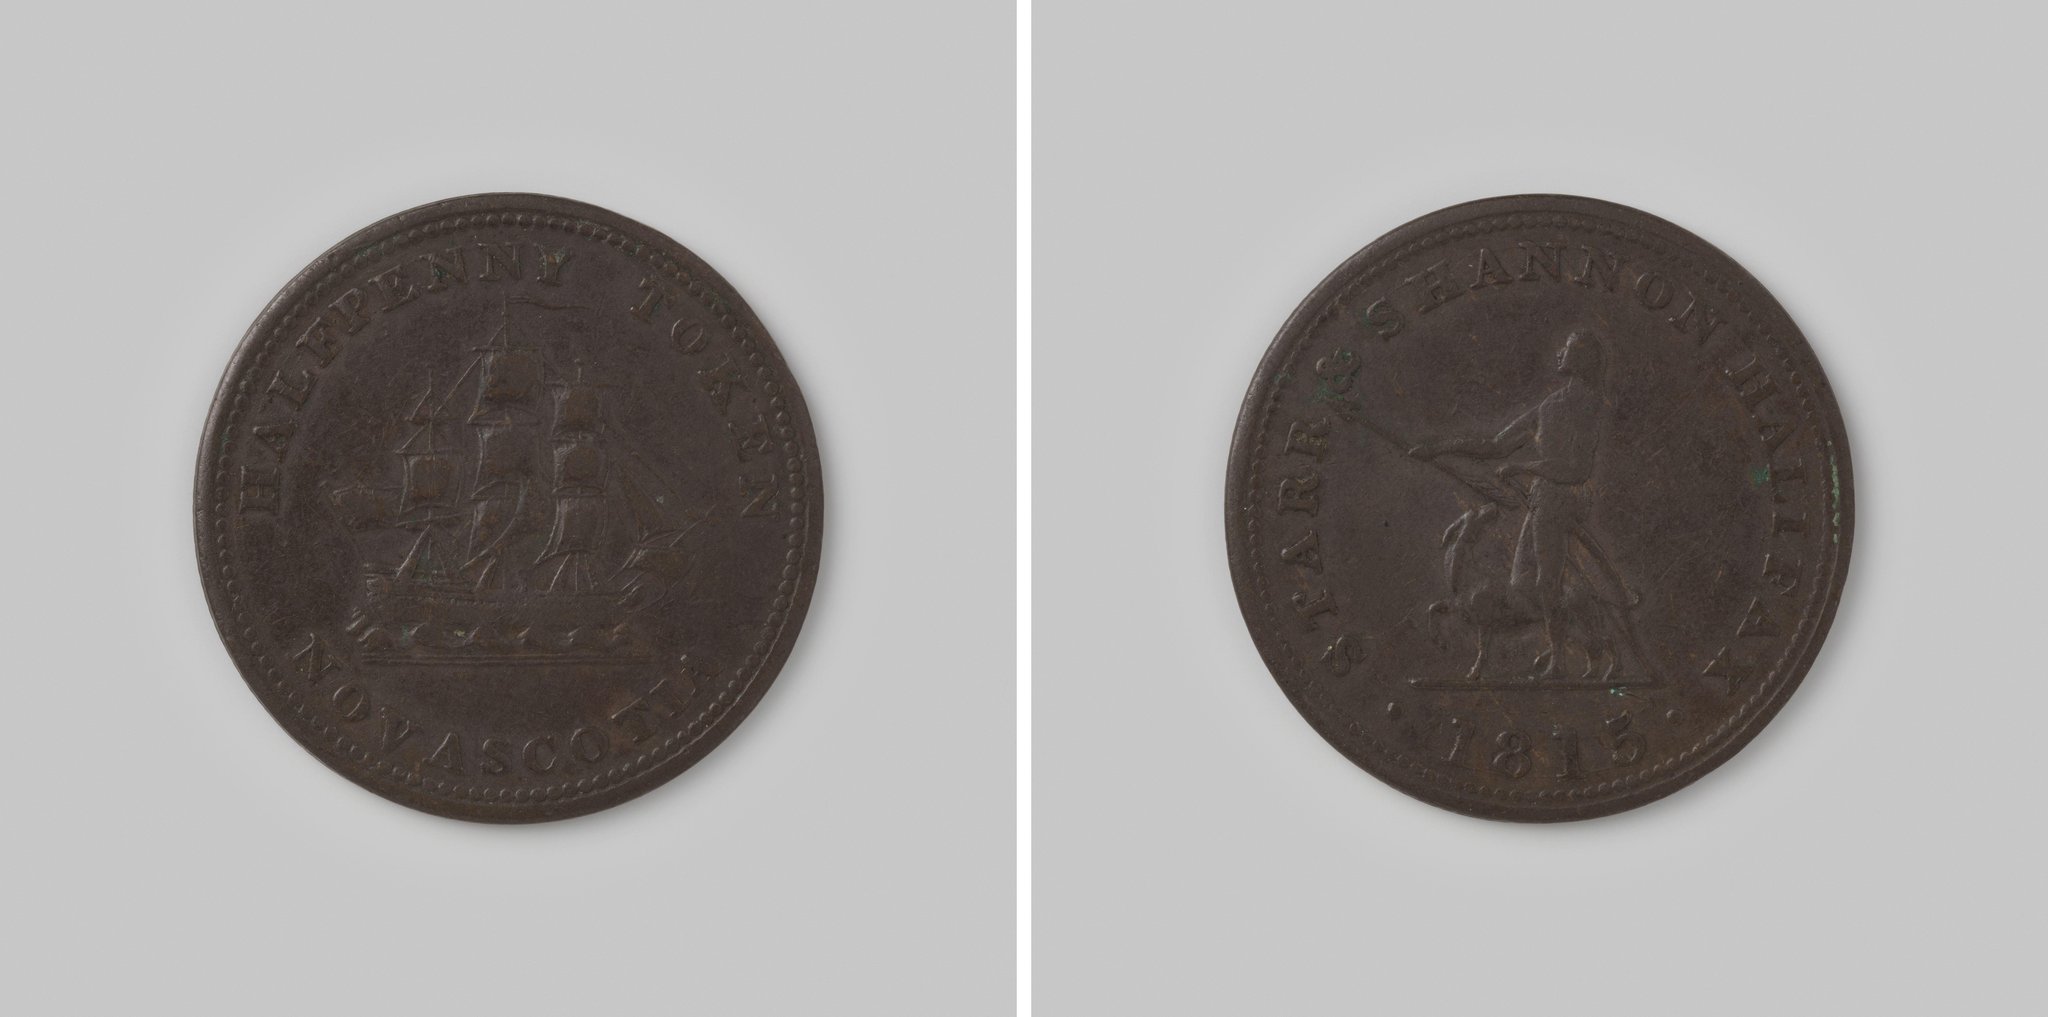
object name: monetary token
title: Nova Scotia, Canada, ½ penny token op naam van Starr & Shannon, Halifax, 1815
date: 1815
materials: bronze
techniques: striking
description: Bronzen particuliere munt. Voorzijde: op zee varend zeilschip naar rechts. Als omschrift waarde- en lands-aanduiding. Keerzijde: man met pijl en boog en hond, lopend naar links. Als omschrift firma- en plaatsaanduiding. Gladde rand.